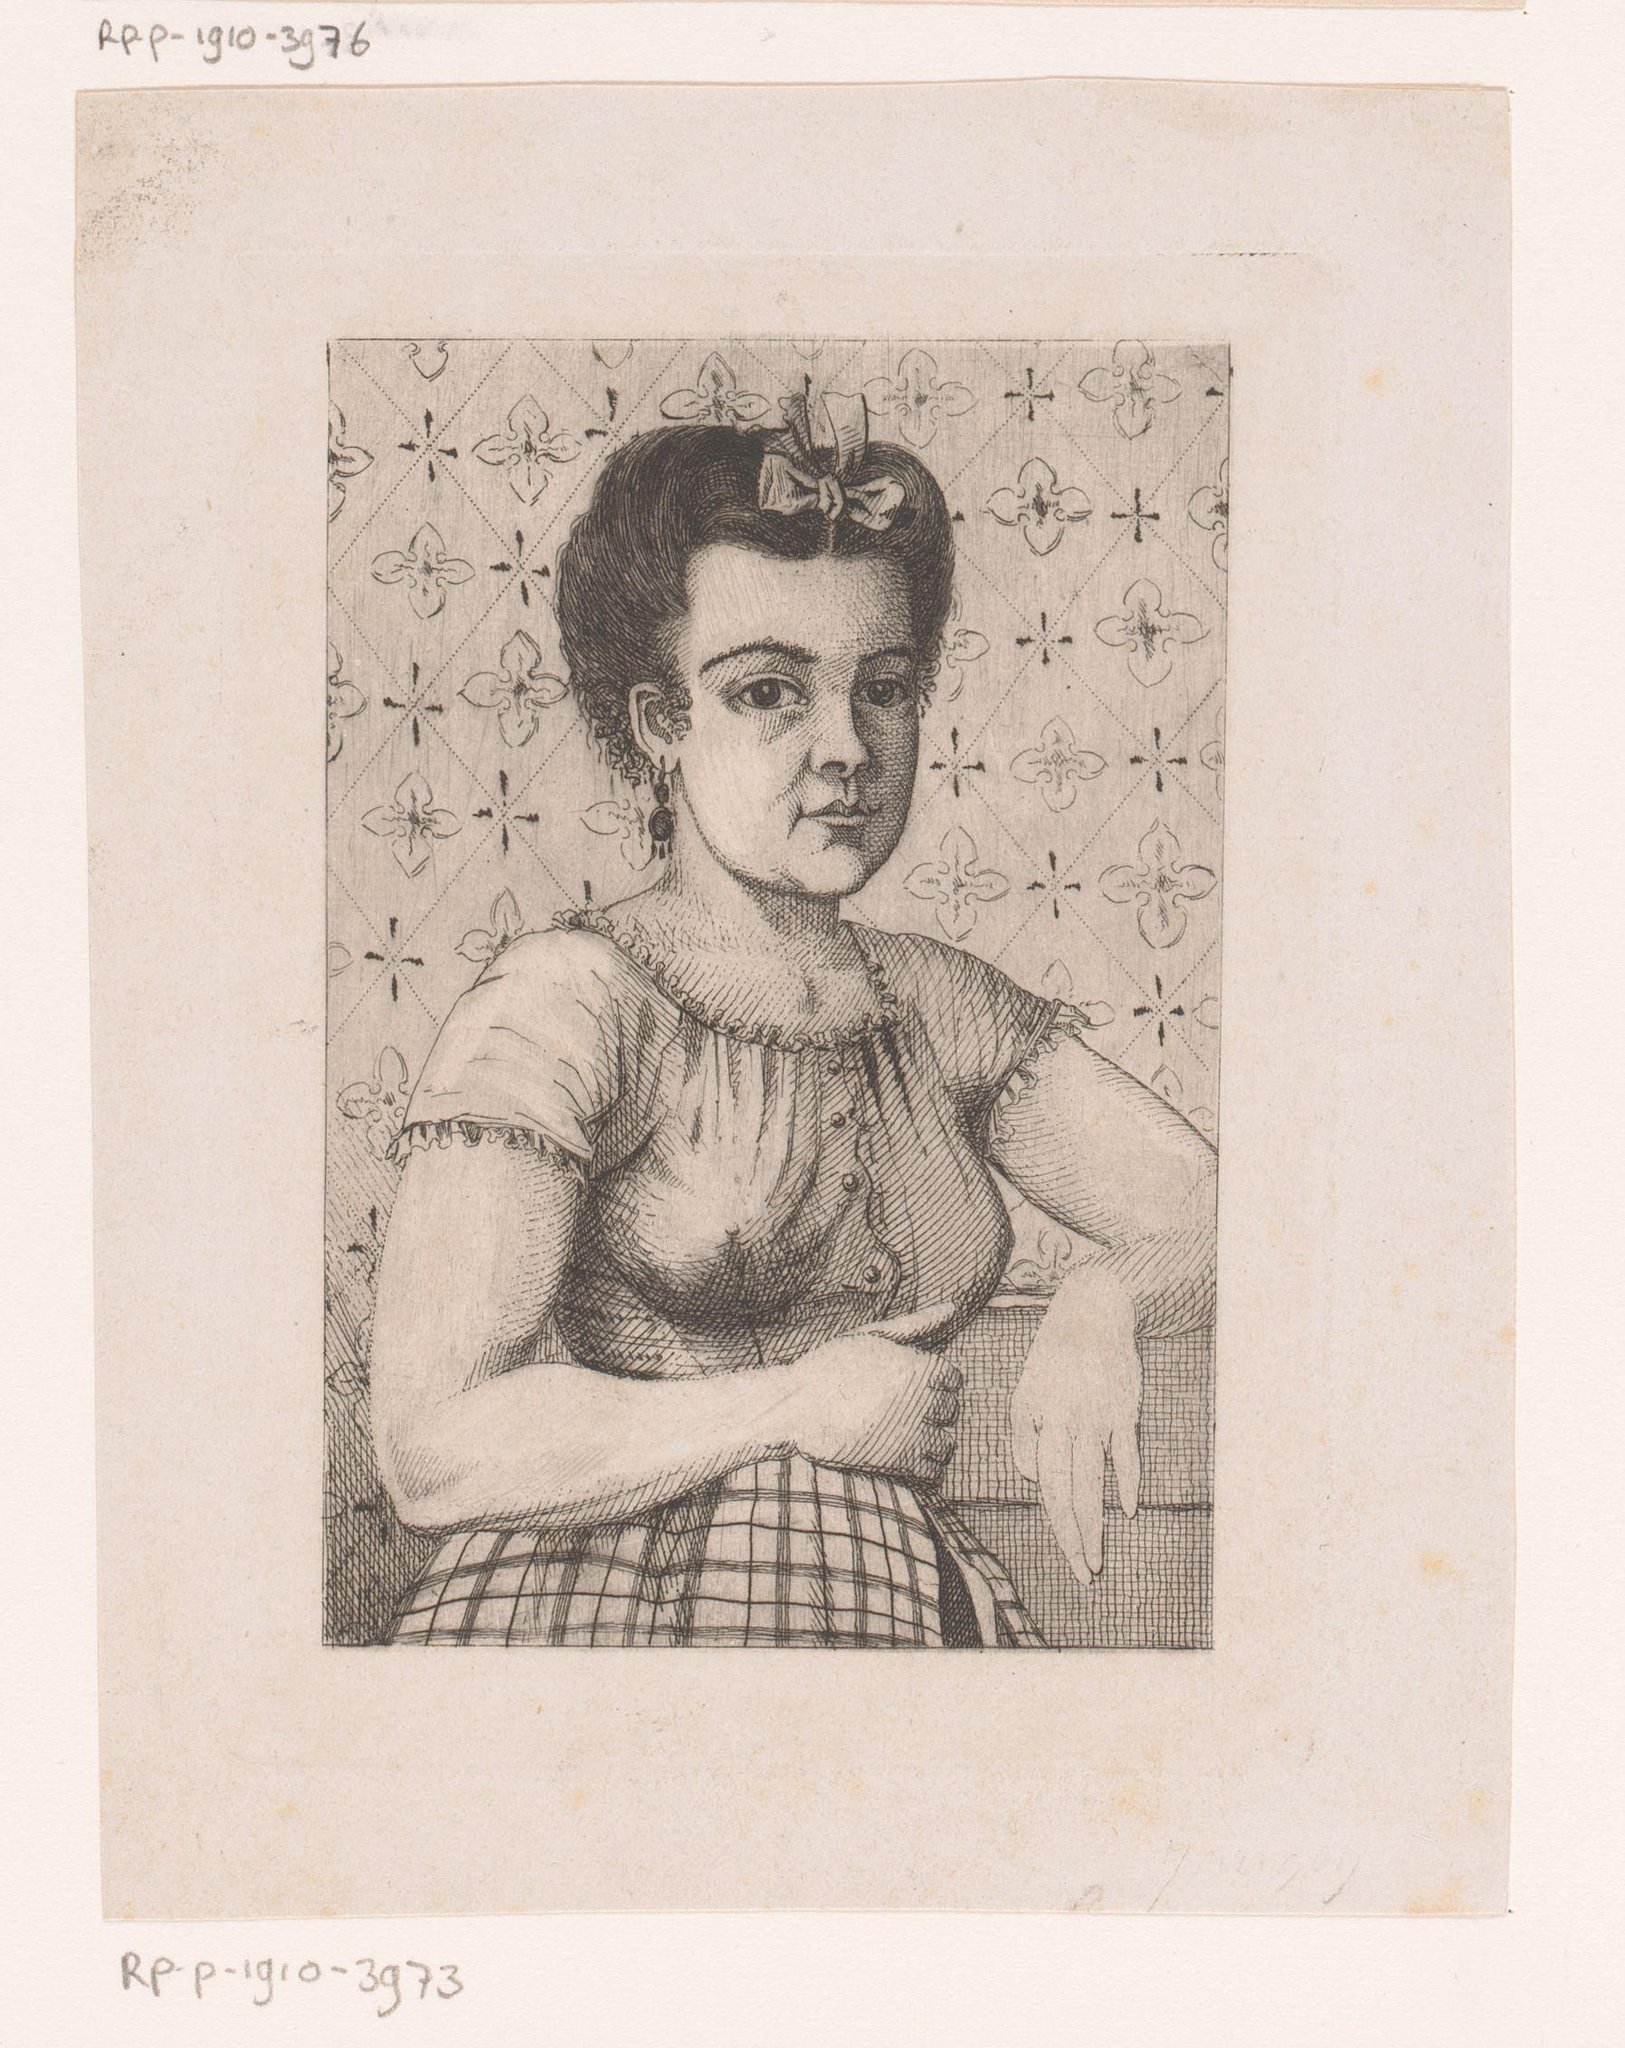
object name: print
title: Portret van een onbekende jonge vrouw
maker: louis jaugey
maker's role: print maker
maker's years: 1837-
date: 1850-1899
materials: paper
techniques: etching, intaglio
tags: adolescent, young woman, maiden, historical persons, standing figure - aa - female human figure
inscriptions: collector's mark: Lugt 2228